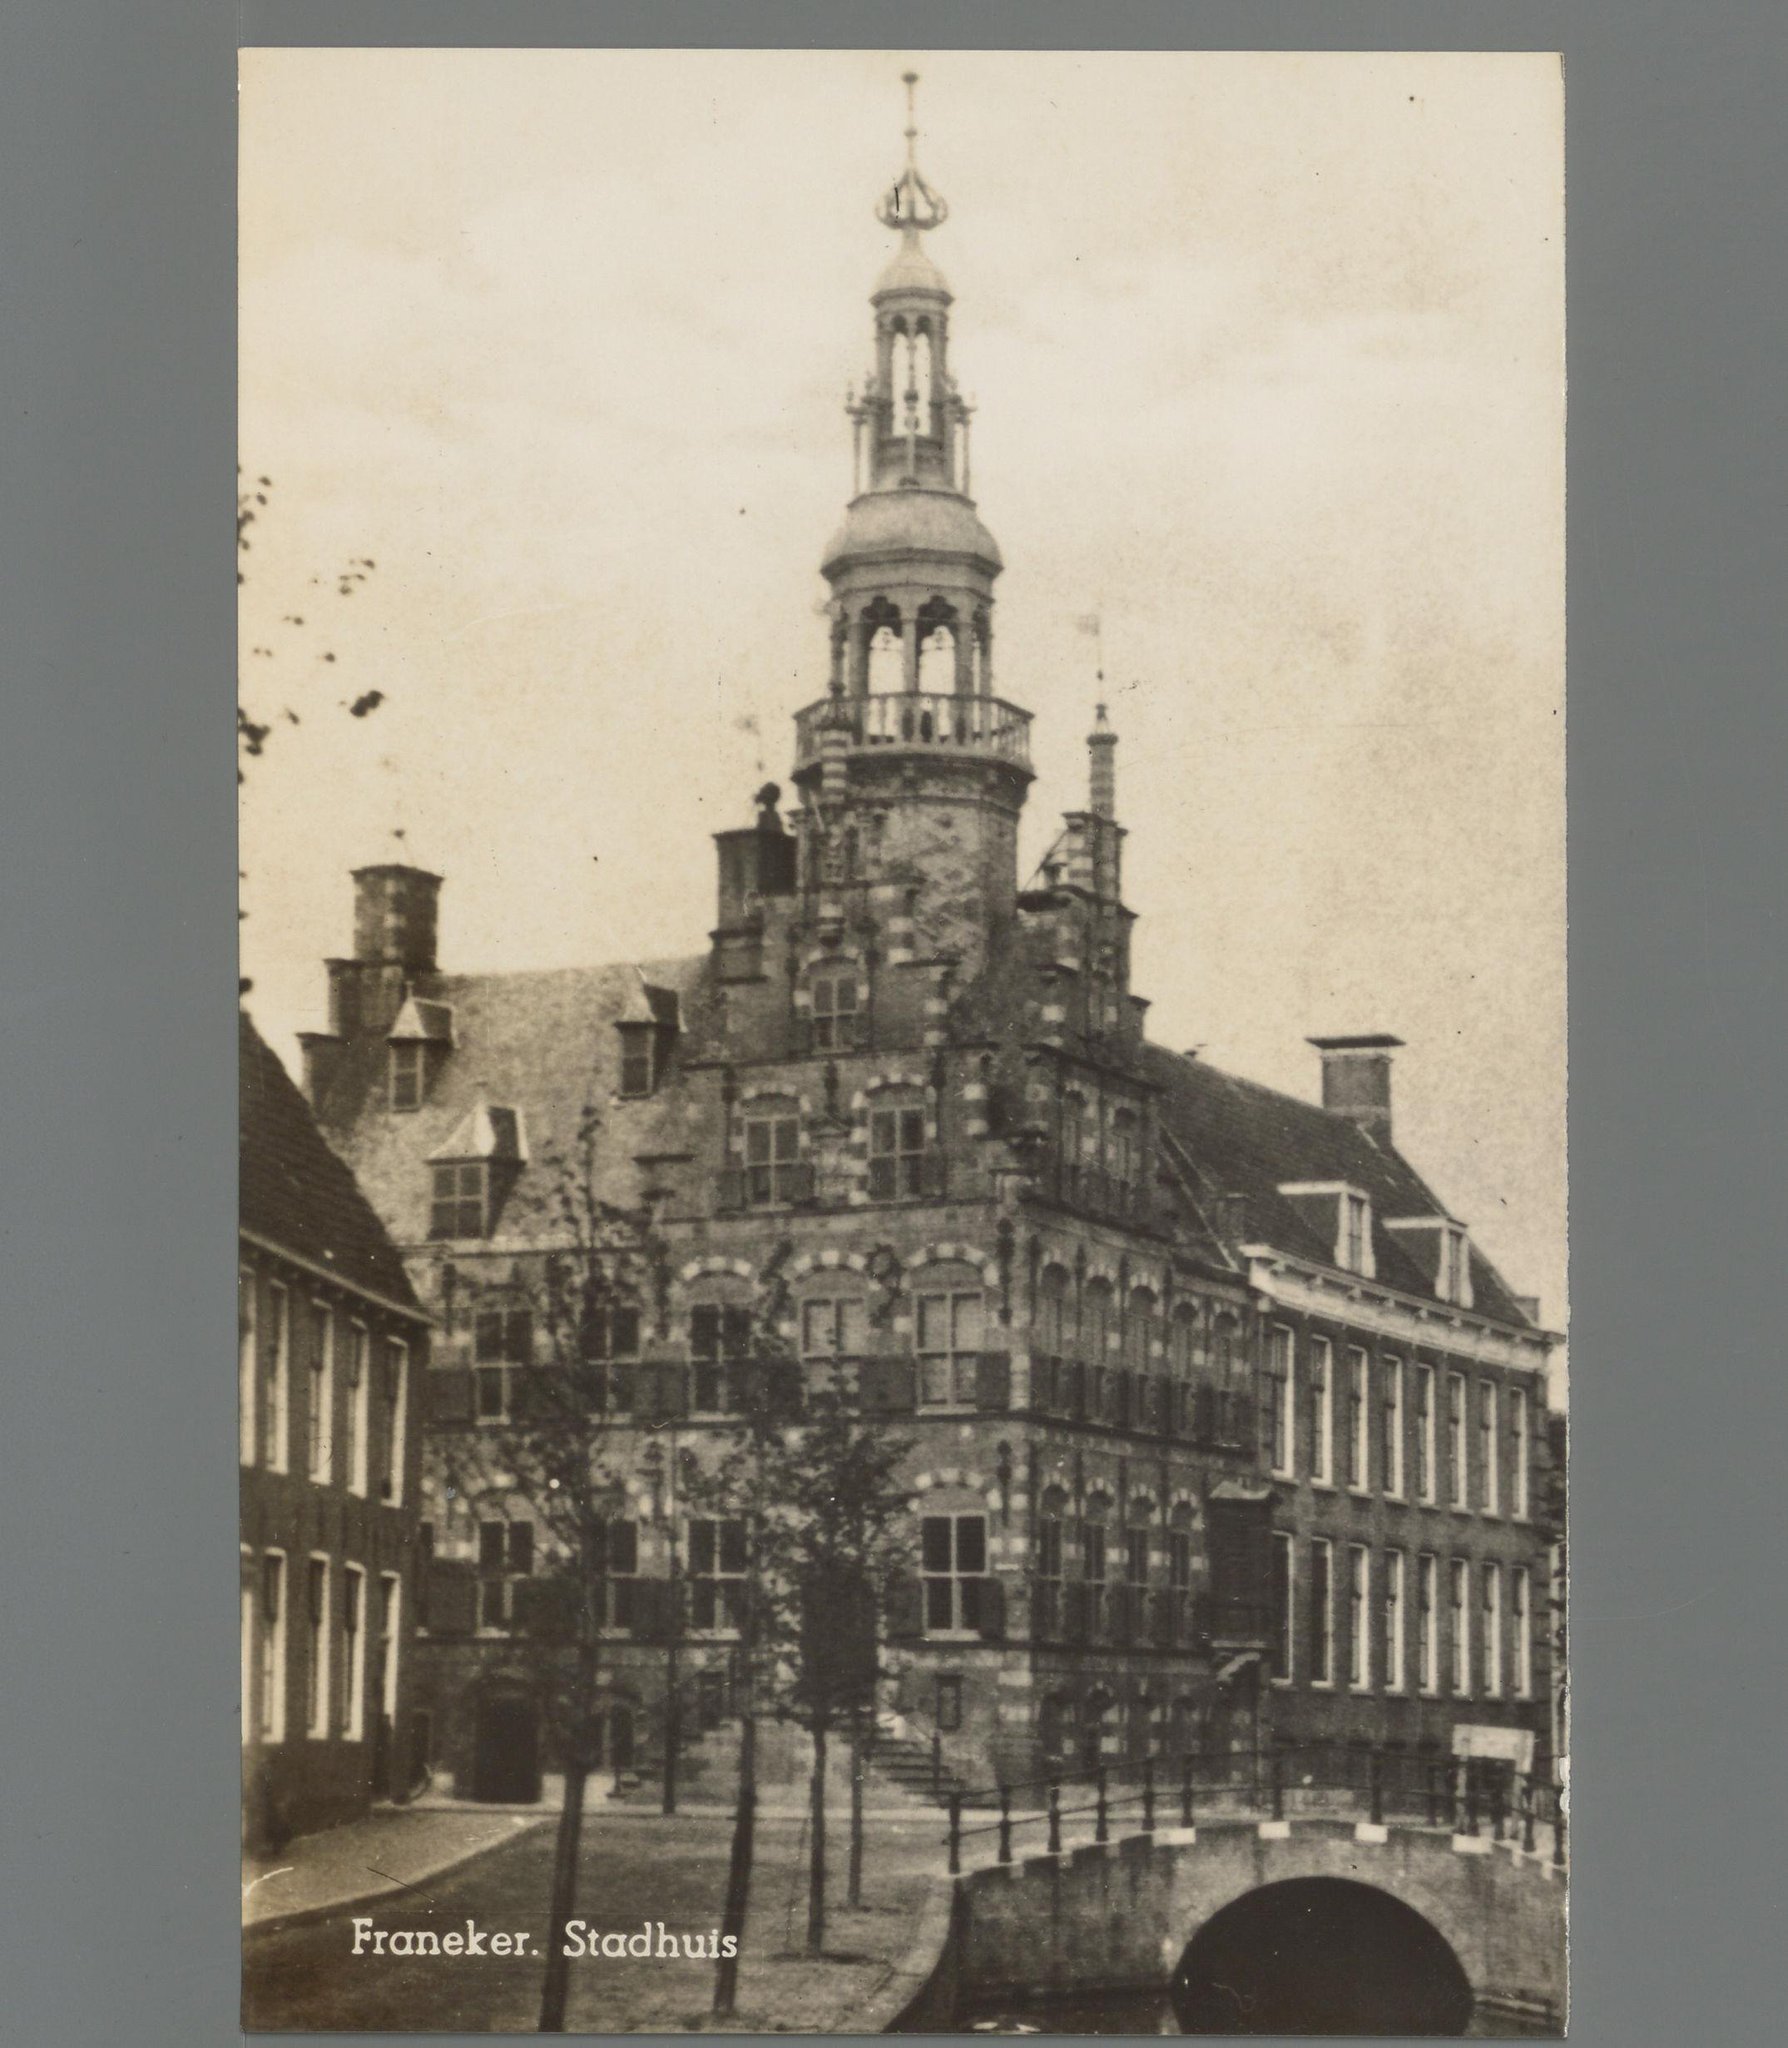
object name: photograph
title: Franeker, Stadhuis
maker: Anonymous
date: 1943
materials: photographic support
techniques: photography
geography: franeker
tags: townhall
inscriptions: number: ‘1943’